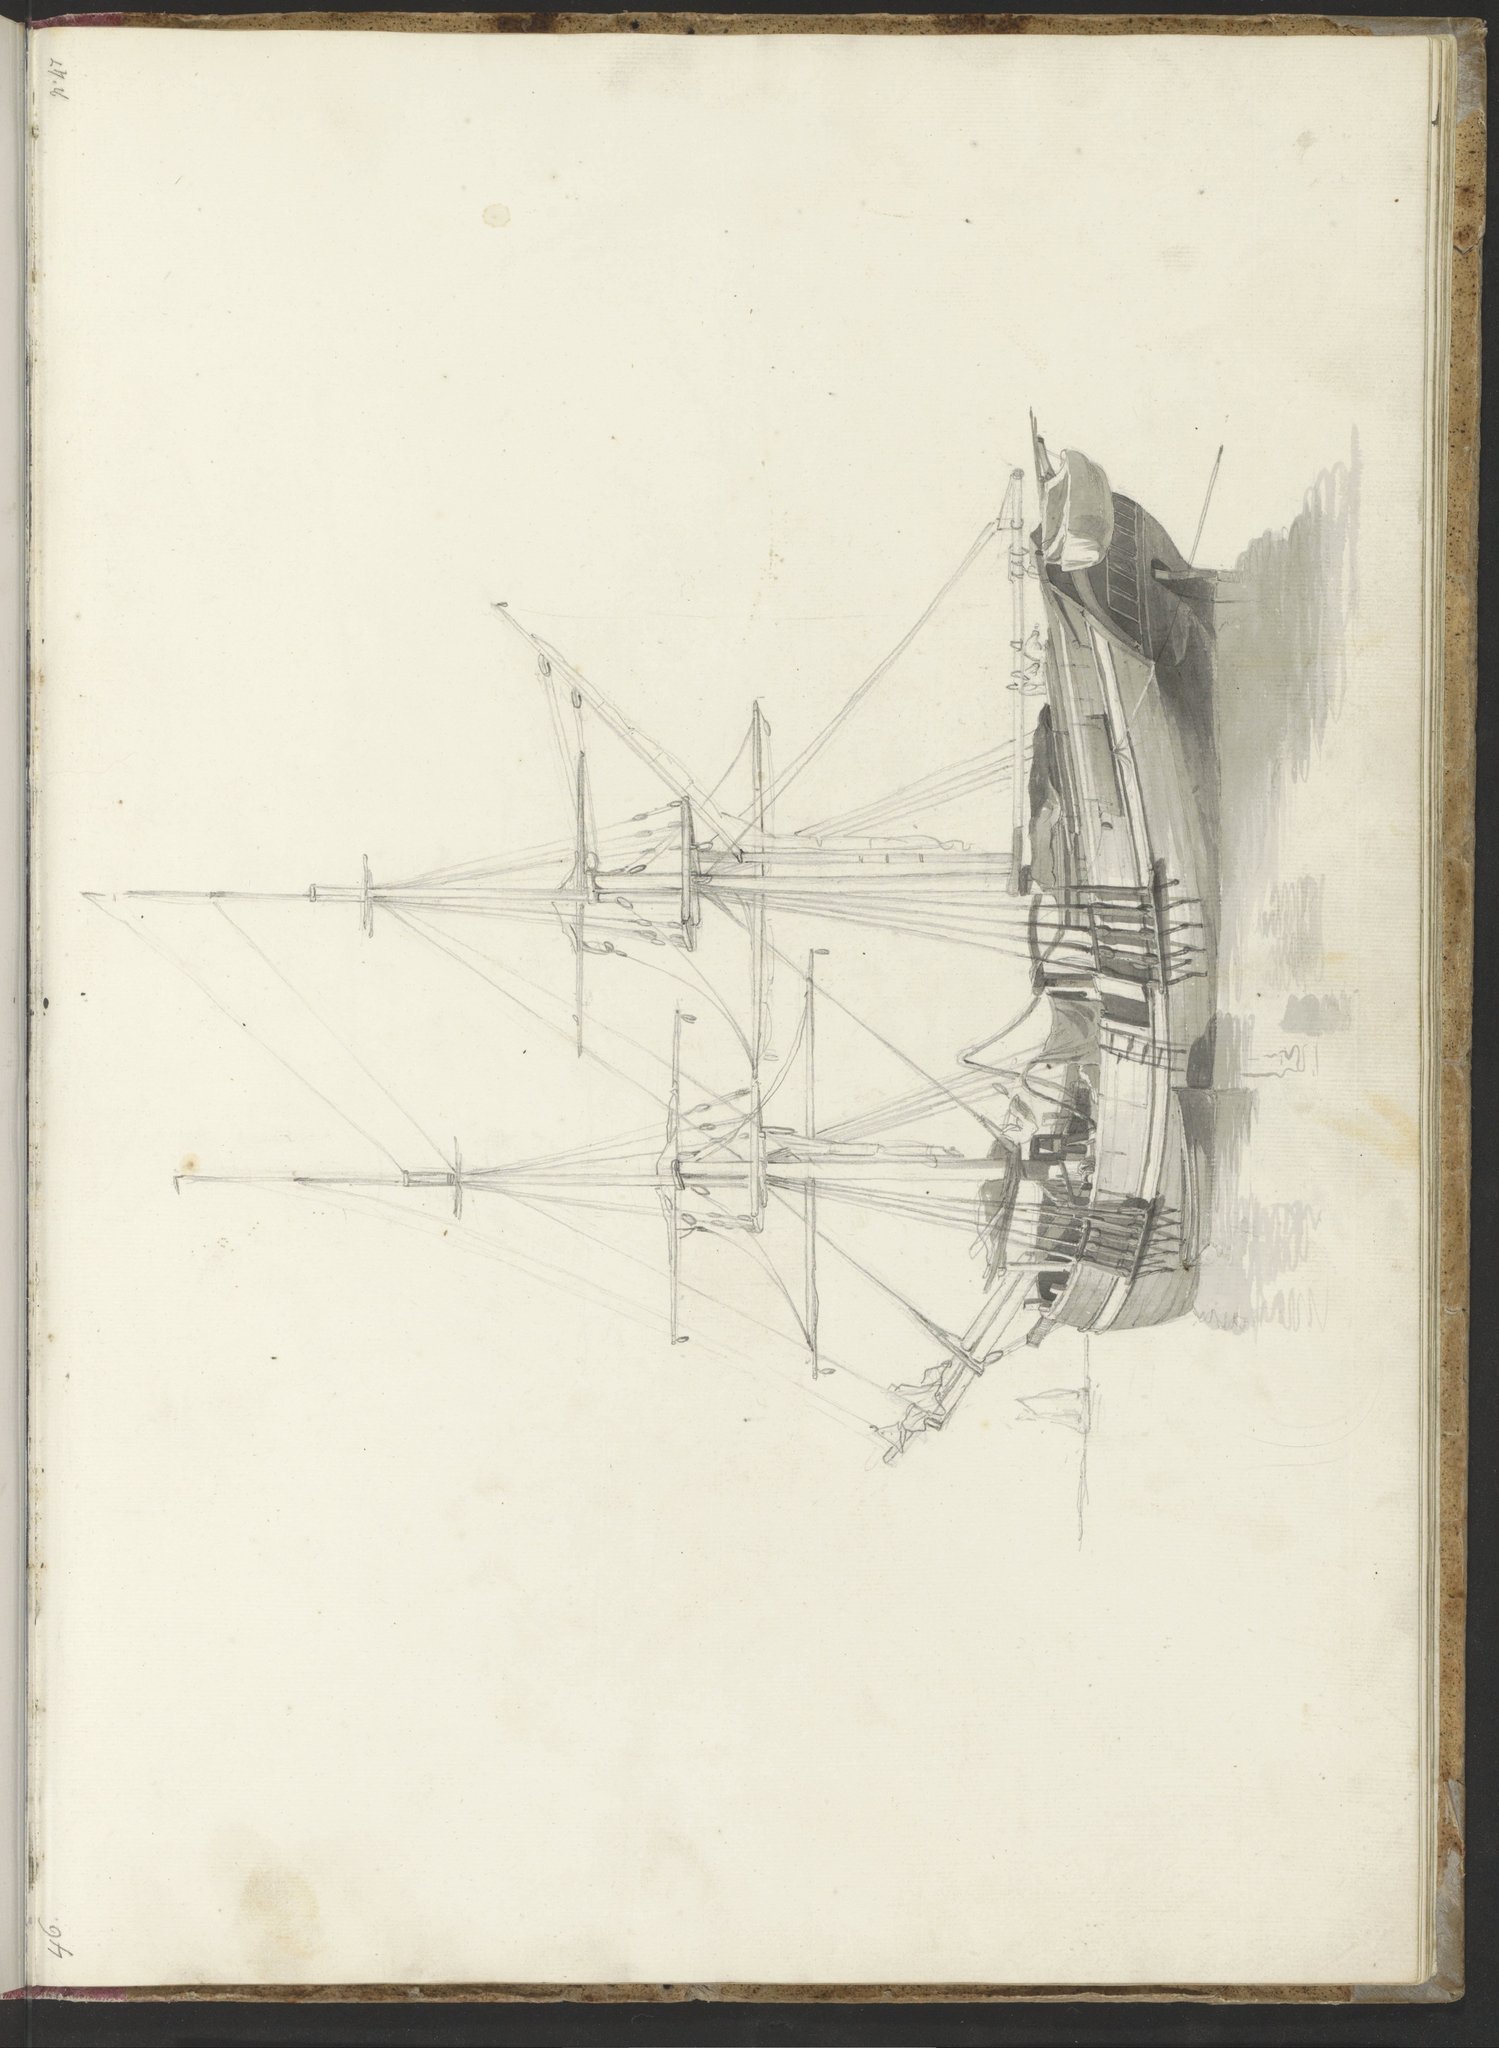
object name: sketchbook leaf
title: Tweemaster op het water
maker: johannes christiaan schotel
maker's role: draughtsman, painter, print maker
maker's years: 1787-1838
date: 1797-1838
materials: paper, pencil, watercolor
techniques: brush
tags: sailing-ship, sailing-boat, landscapes with waters, waterscapes, seascapes (in the temperate zone)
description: Blad 46 recto uit een schetsboek met 65 bladen.